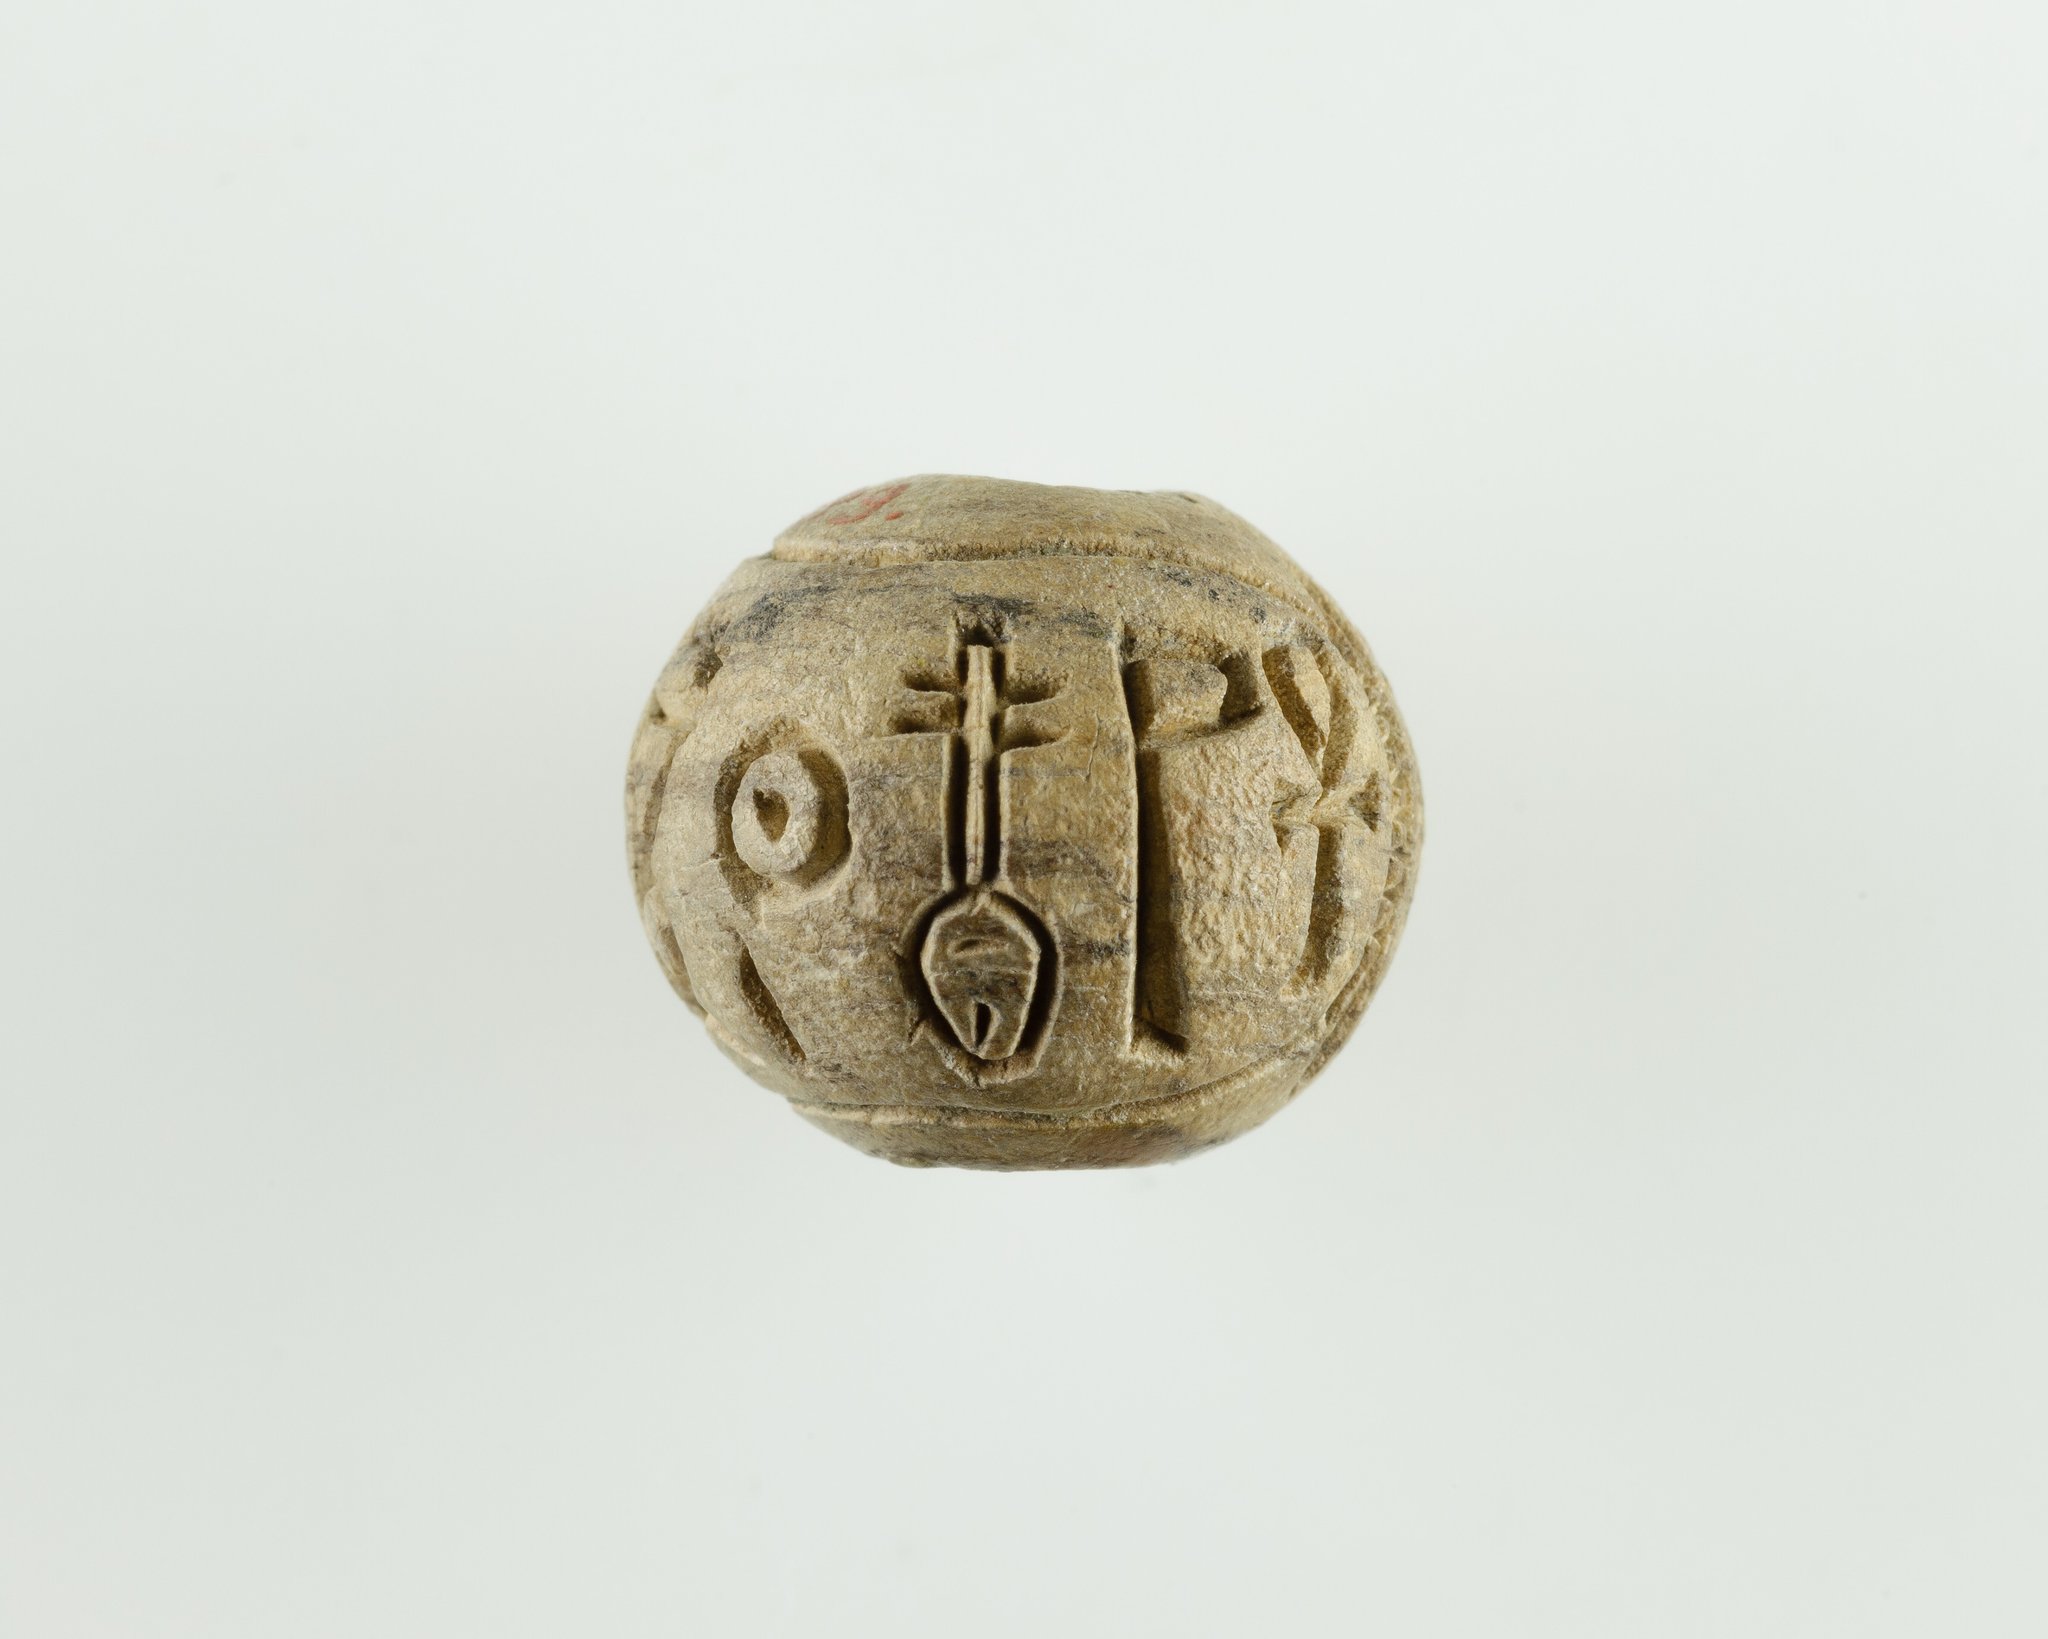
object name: bead, king iaib wahibre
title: Bead with the Name of King Iaib Wahibre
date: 1711-1700 BCE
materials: stone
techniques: glazing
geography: egypt